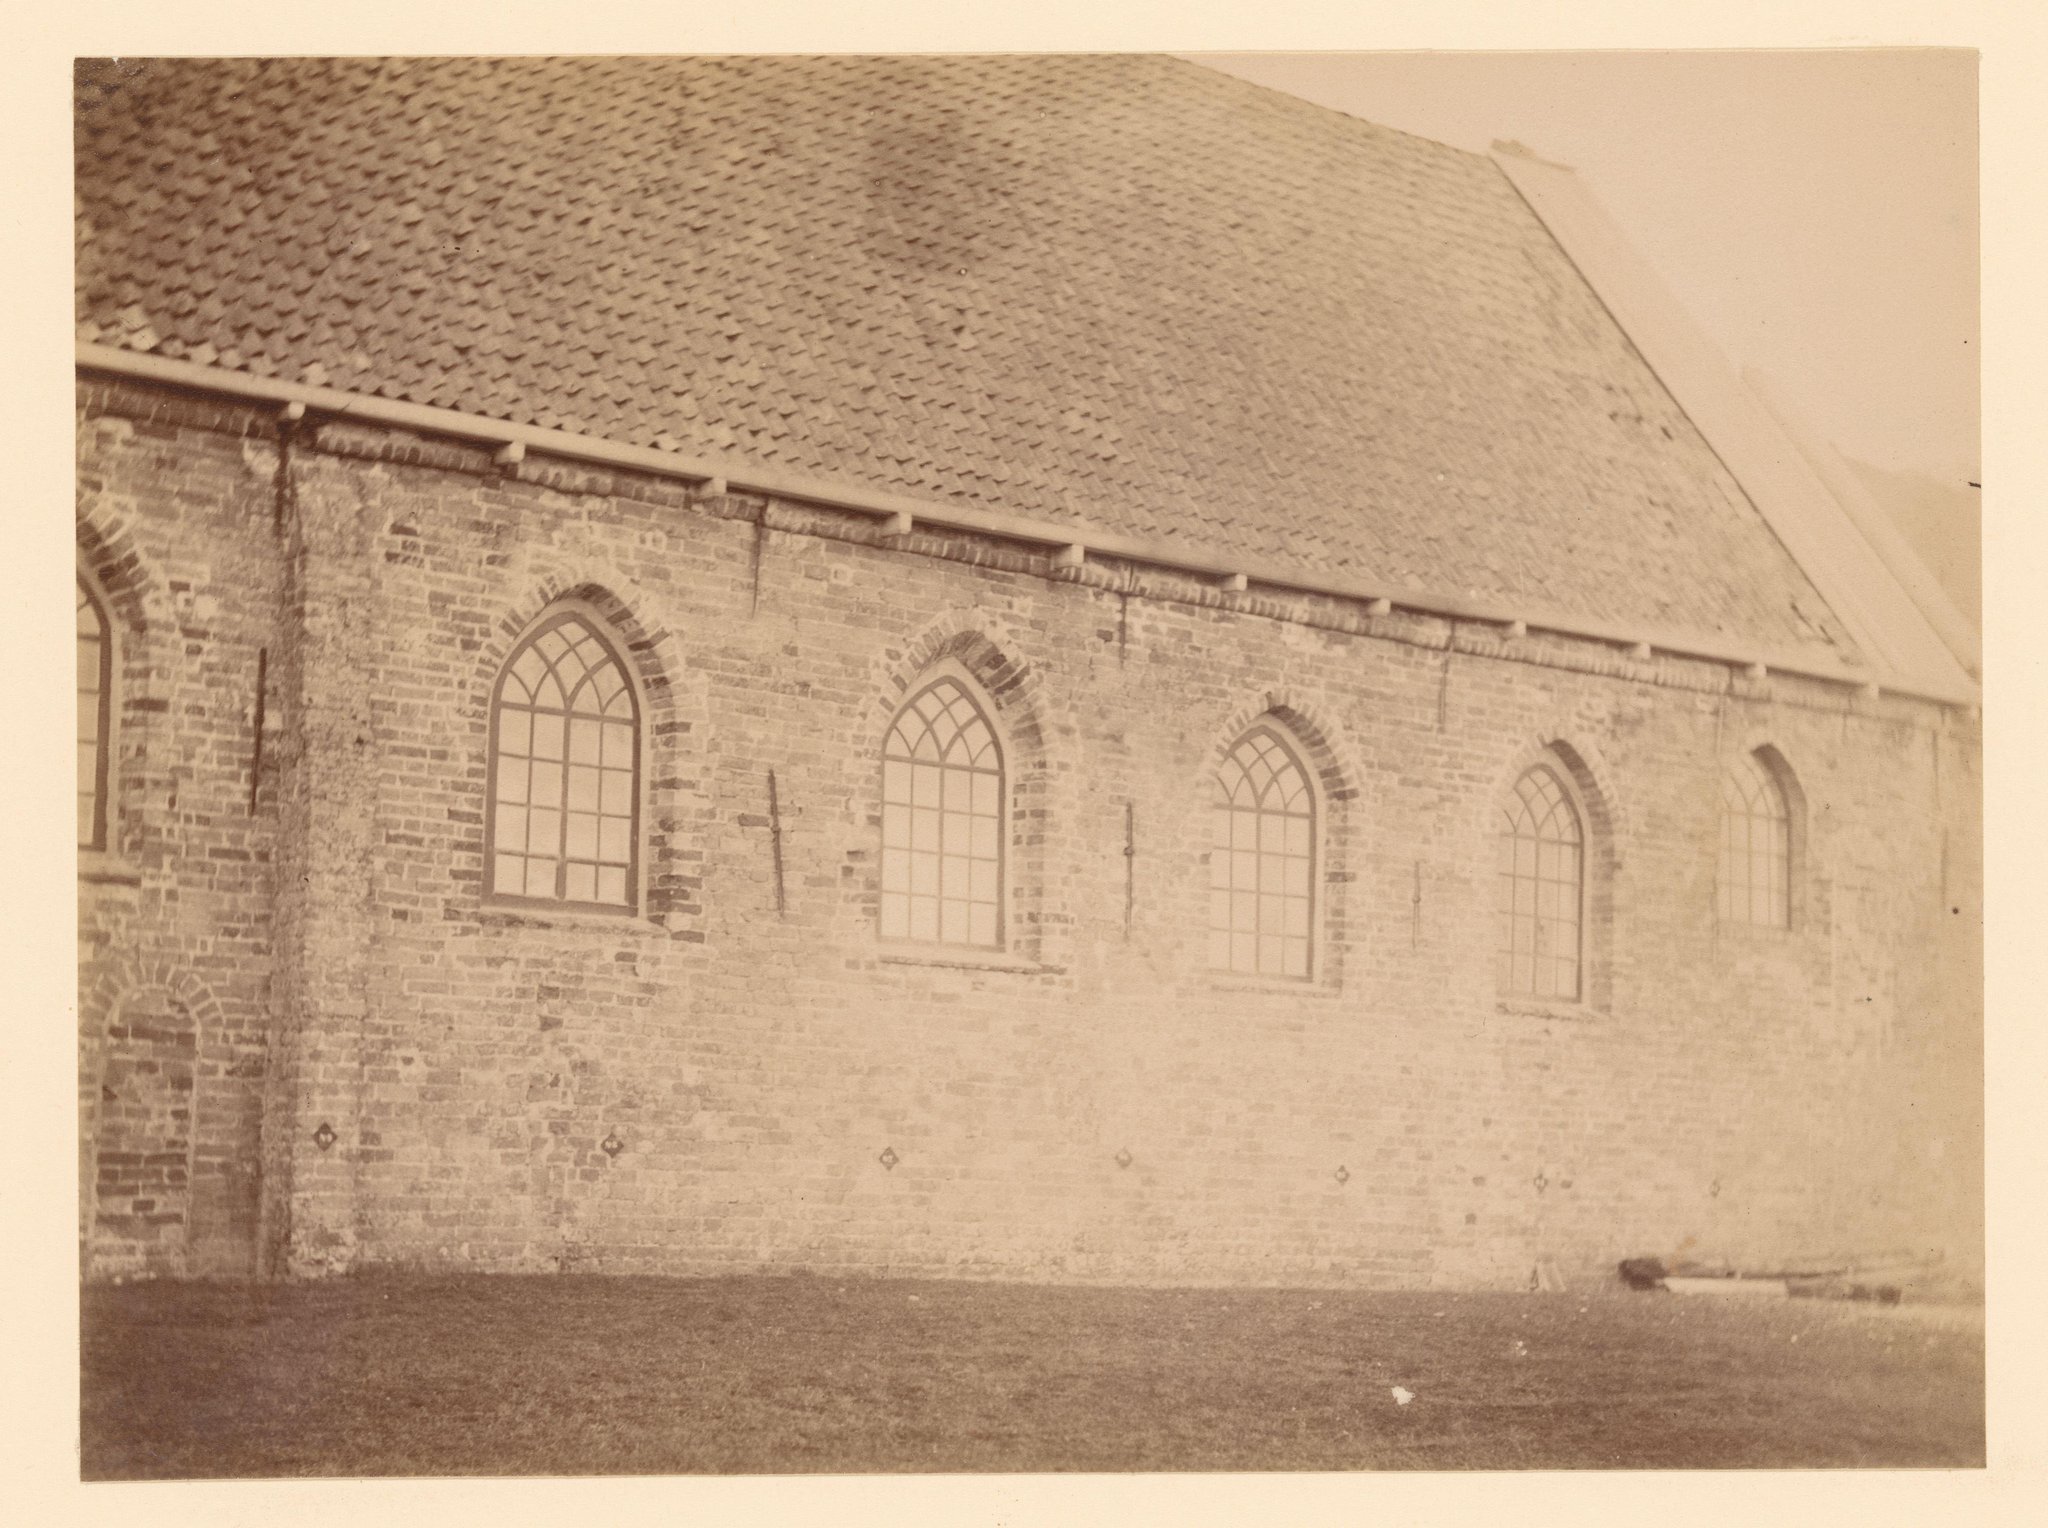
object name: photograph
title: Gedeelte van de Nicolaaskerk te Wieuwerd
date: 1888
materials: cardboard, photographic support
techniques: albumen print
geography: wieuwerd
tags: church (exterior)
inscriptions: annotation: ‘Wiewerd / N.H. Kerk / Baarderadeel’, annotation: ‘Wiewerd/ Wiewerd/ gem. Baarderadeel’